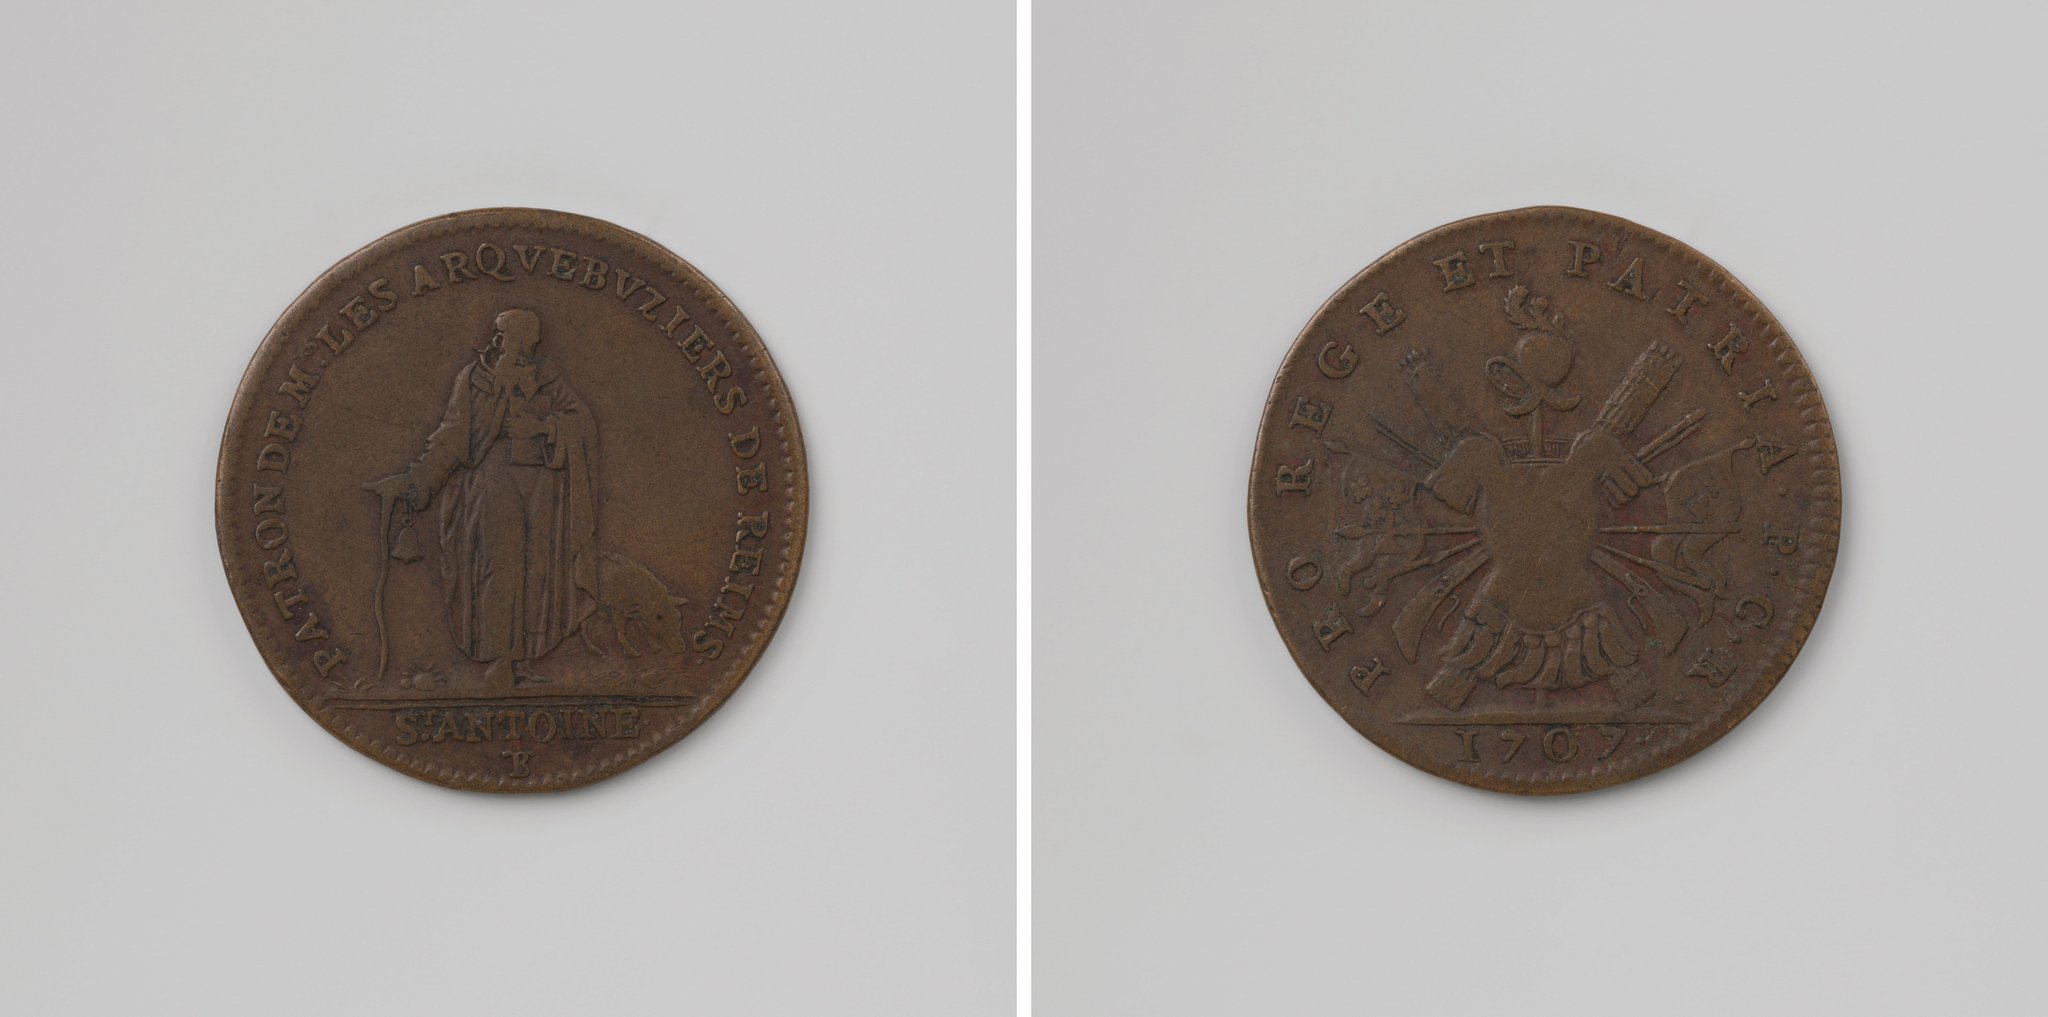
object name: marksman medal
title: Schutterij van St. Antonis te Reims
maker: thomas bernard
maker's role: artist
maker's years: 1650-1713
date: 1707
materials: copper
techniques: striking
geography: paris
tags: reims